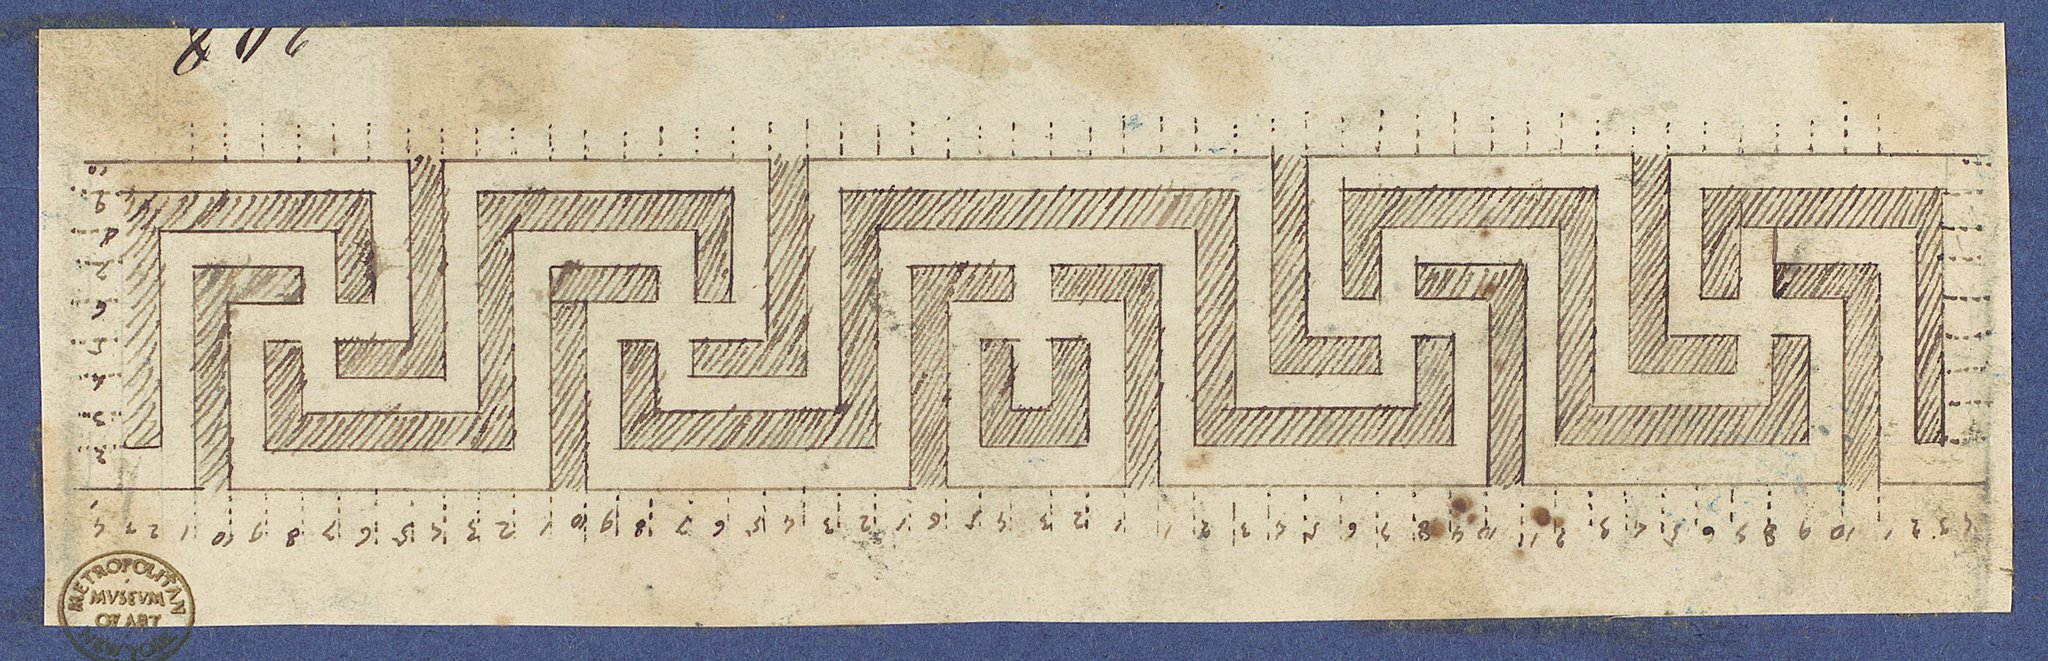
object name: drawing ornament architecture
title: Fret, from Chippendale Drawings, Vol. II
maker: thomas chippendale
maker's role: artist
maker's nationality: british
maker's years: 1718-1779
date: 1760-1770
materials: ink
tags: ornament